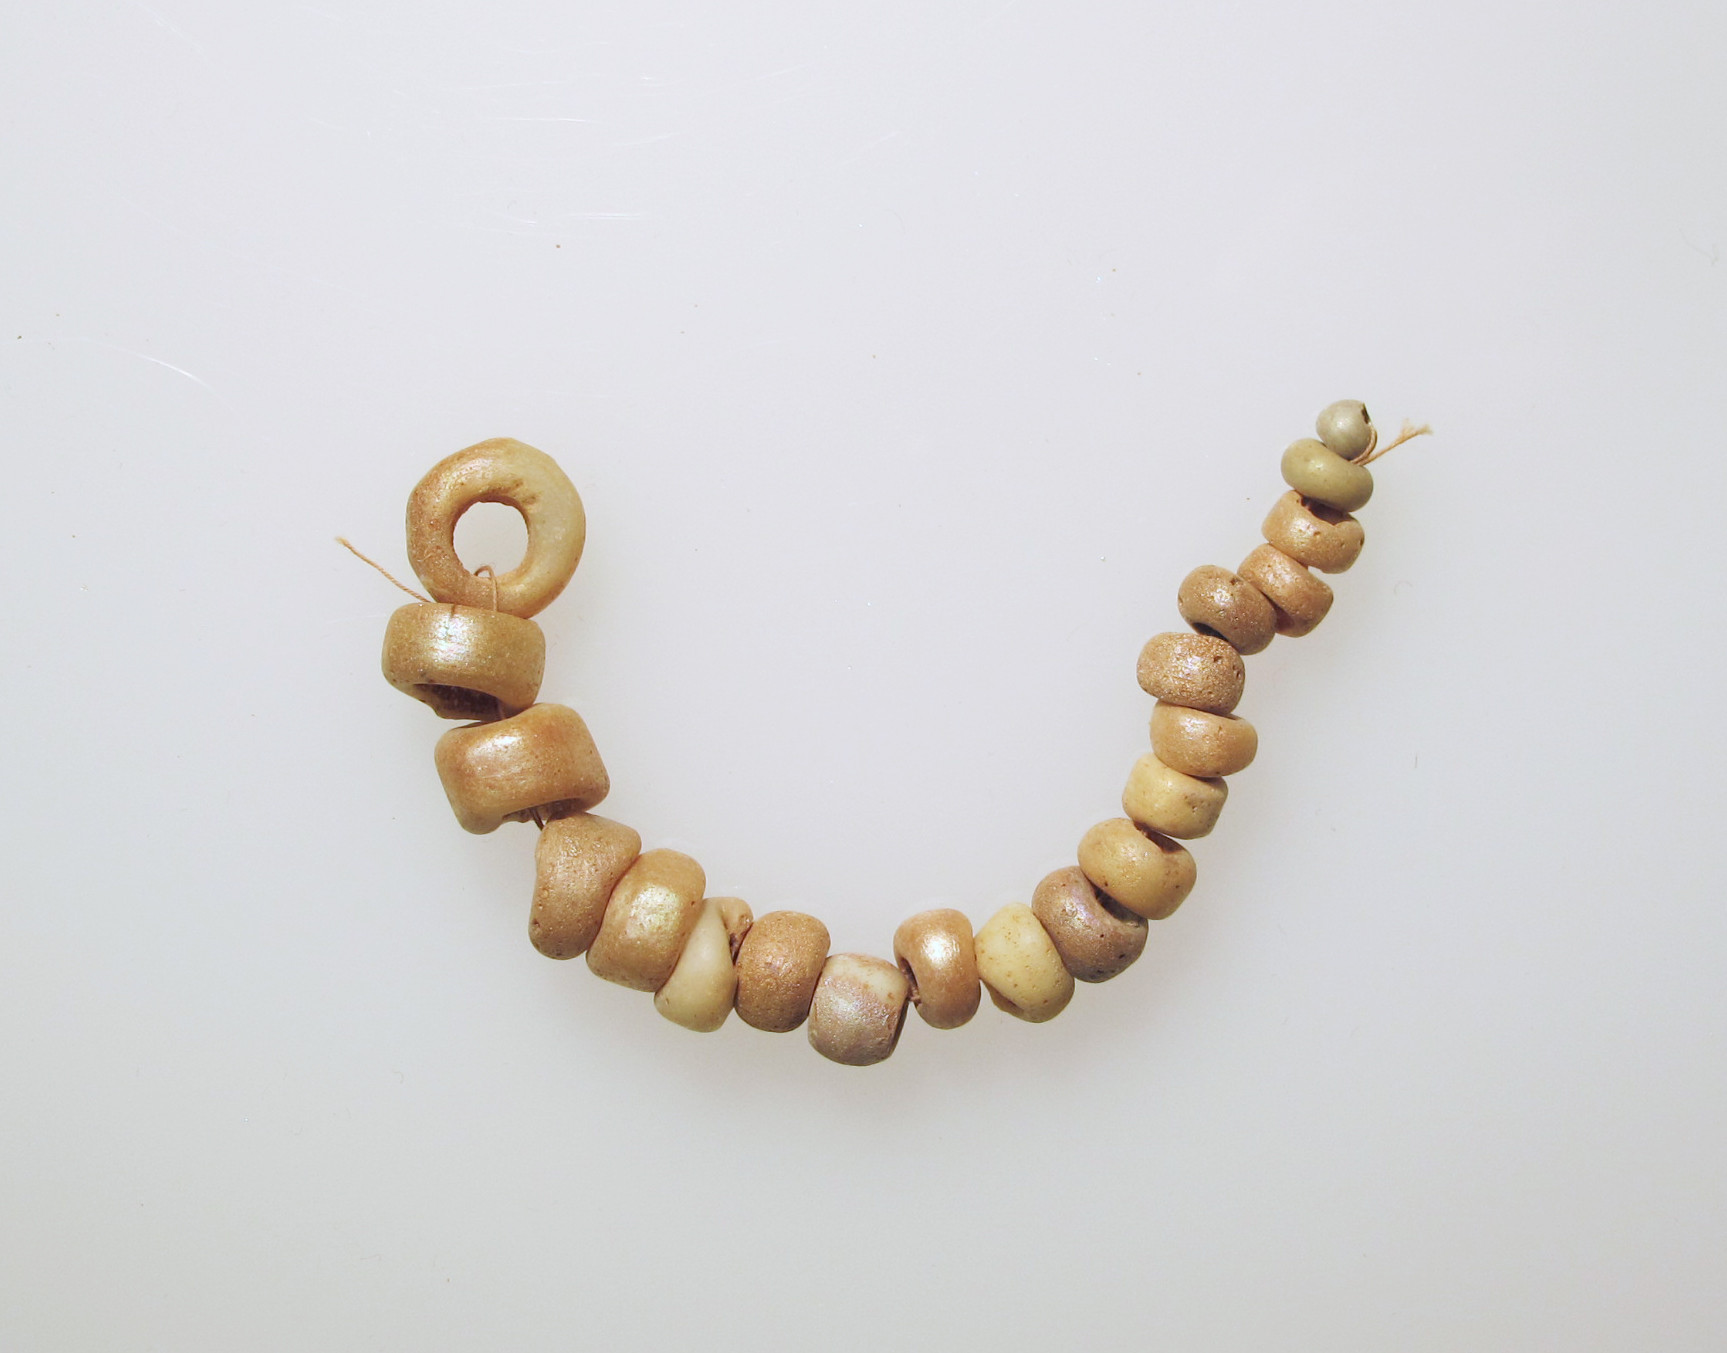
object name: bead, 20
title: Beads, 20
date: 7000 BCE-330 CE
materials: glass